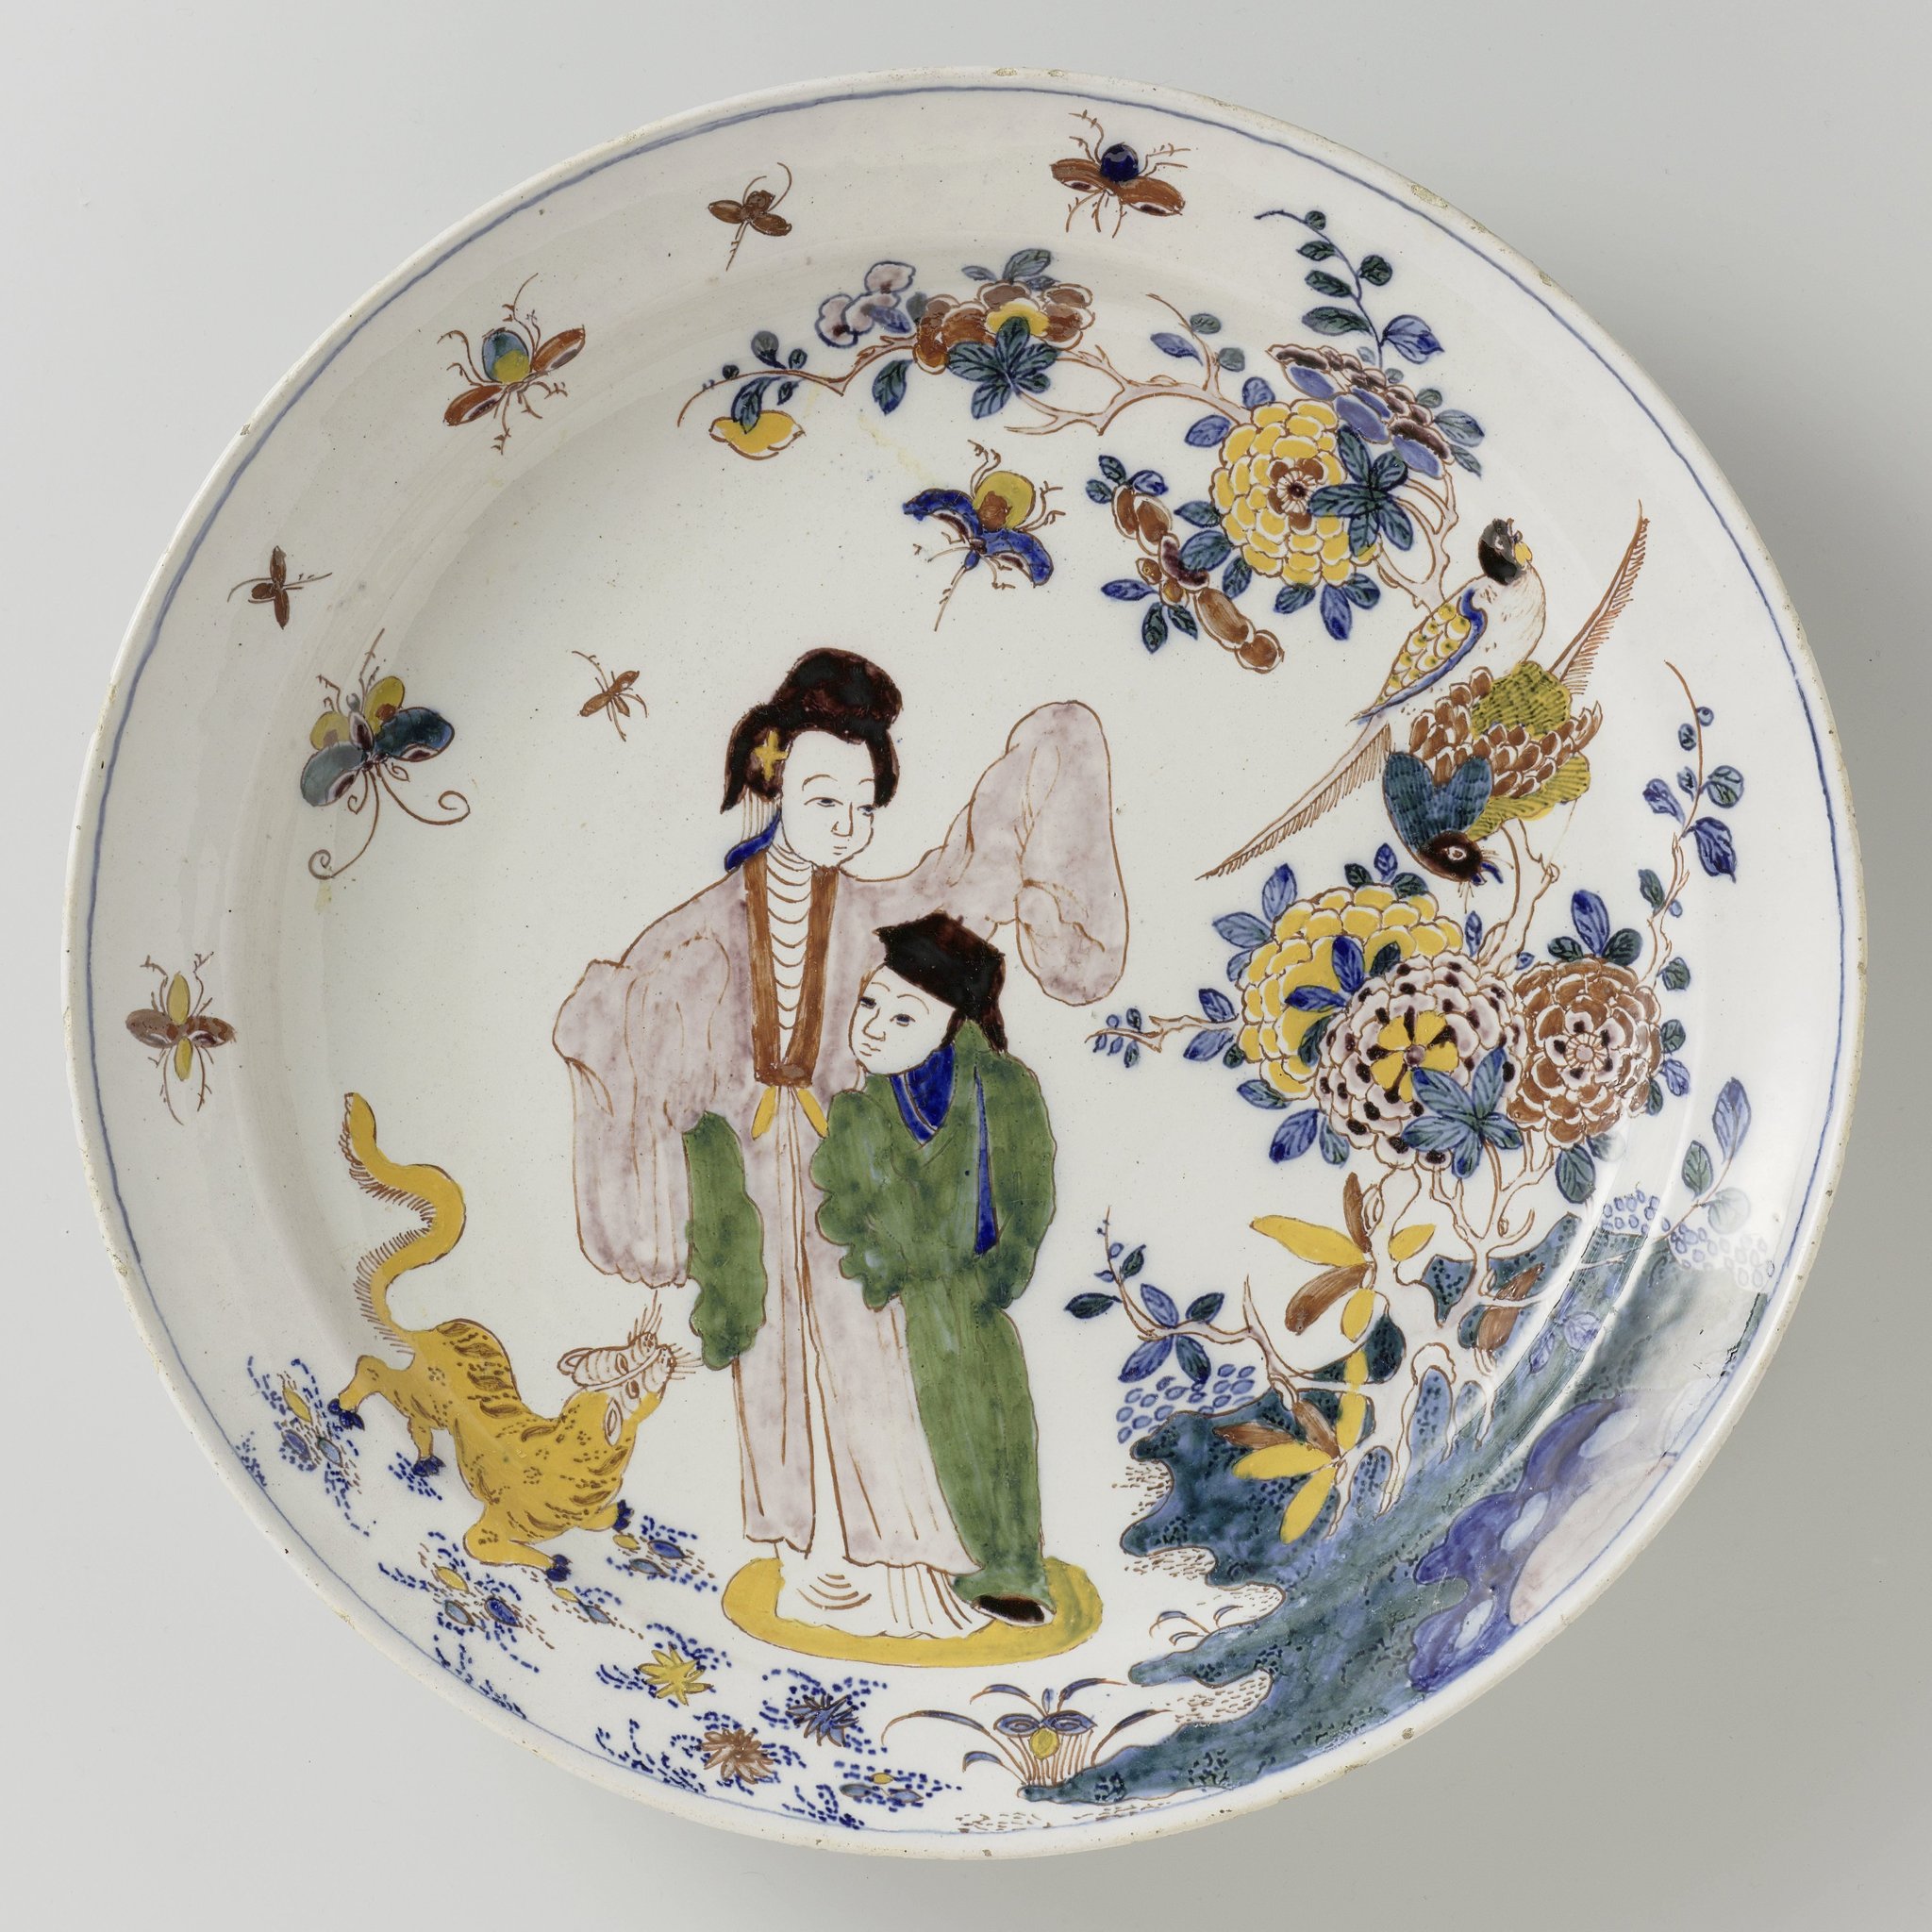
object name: platter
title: Schotel van veelkleurig beschilderde faience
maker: Anonymous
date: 1730-1770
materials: faience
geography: delft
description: Schotel van aardewerk bedekt met wit tinglazuur, waarop een voorstelling op het plat doorgaande over de rand geschilderd is in blauw, groen, geel, rood, violet en paarsbruin. Voorgesteld zijn twee Chinese figuren, een vrouw en een kind, staande, tegen elkaar geleund, op een geel ovaal grondje. Links van hen een gele tijger, rechts rotsen met bloeiende planten met twee vogels. In de lucht een aantal insekten. Rode contouren. Een blauwe bies langs de rand.